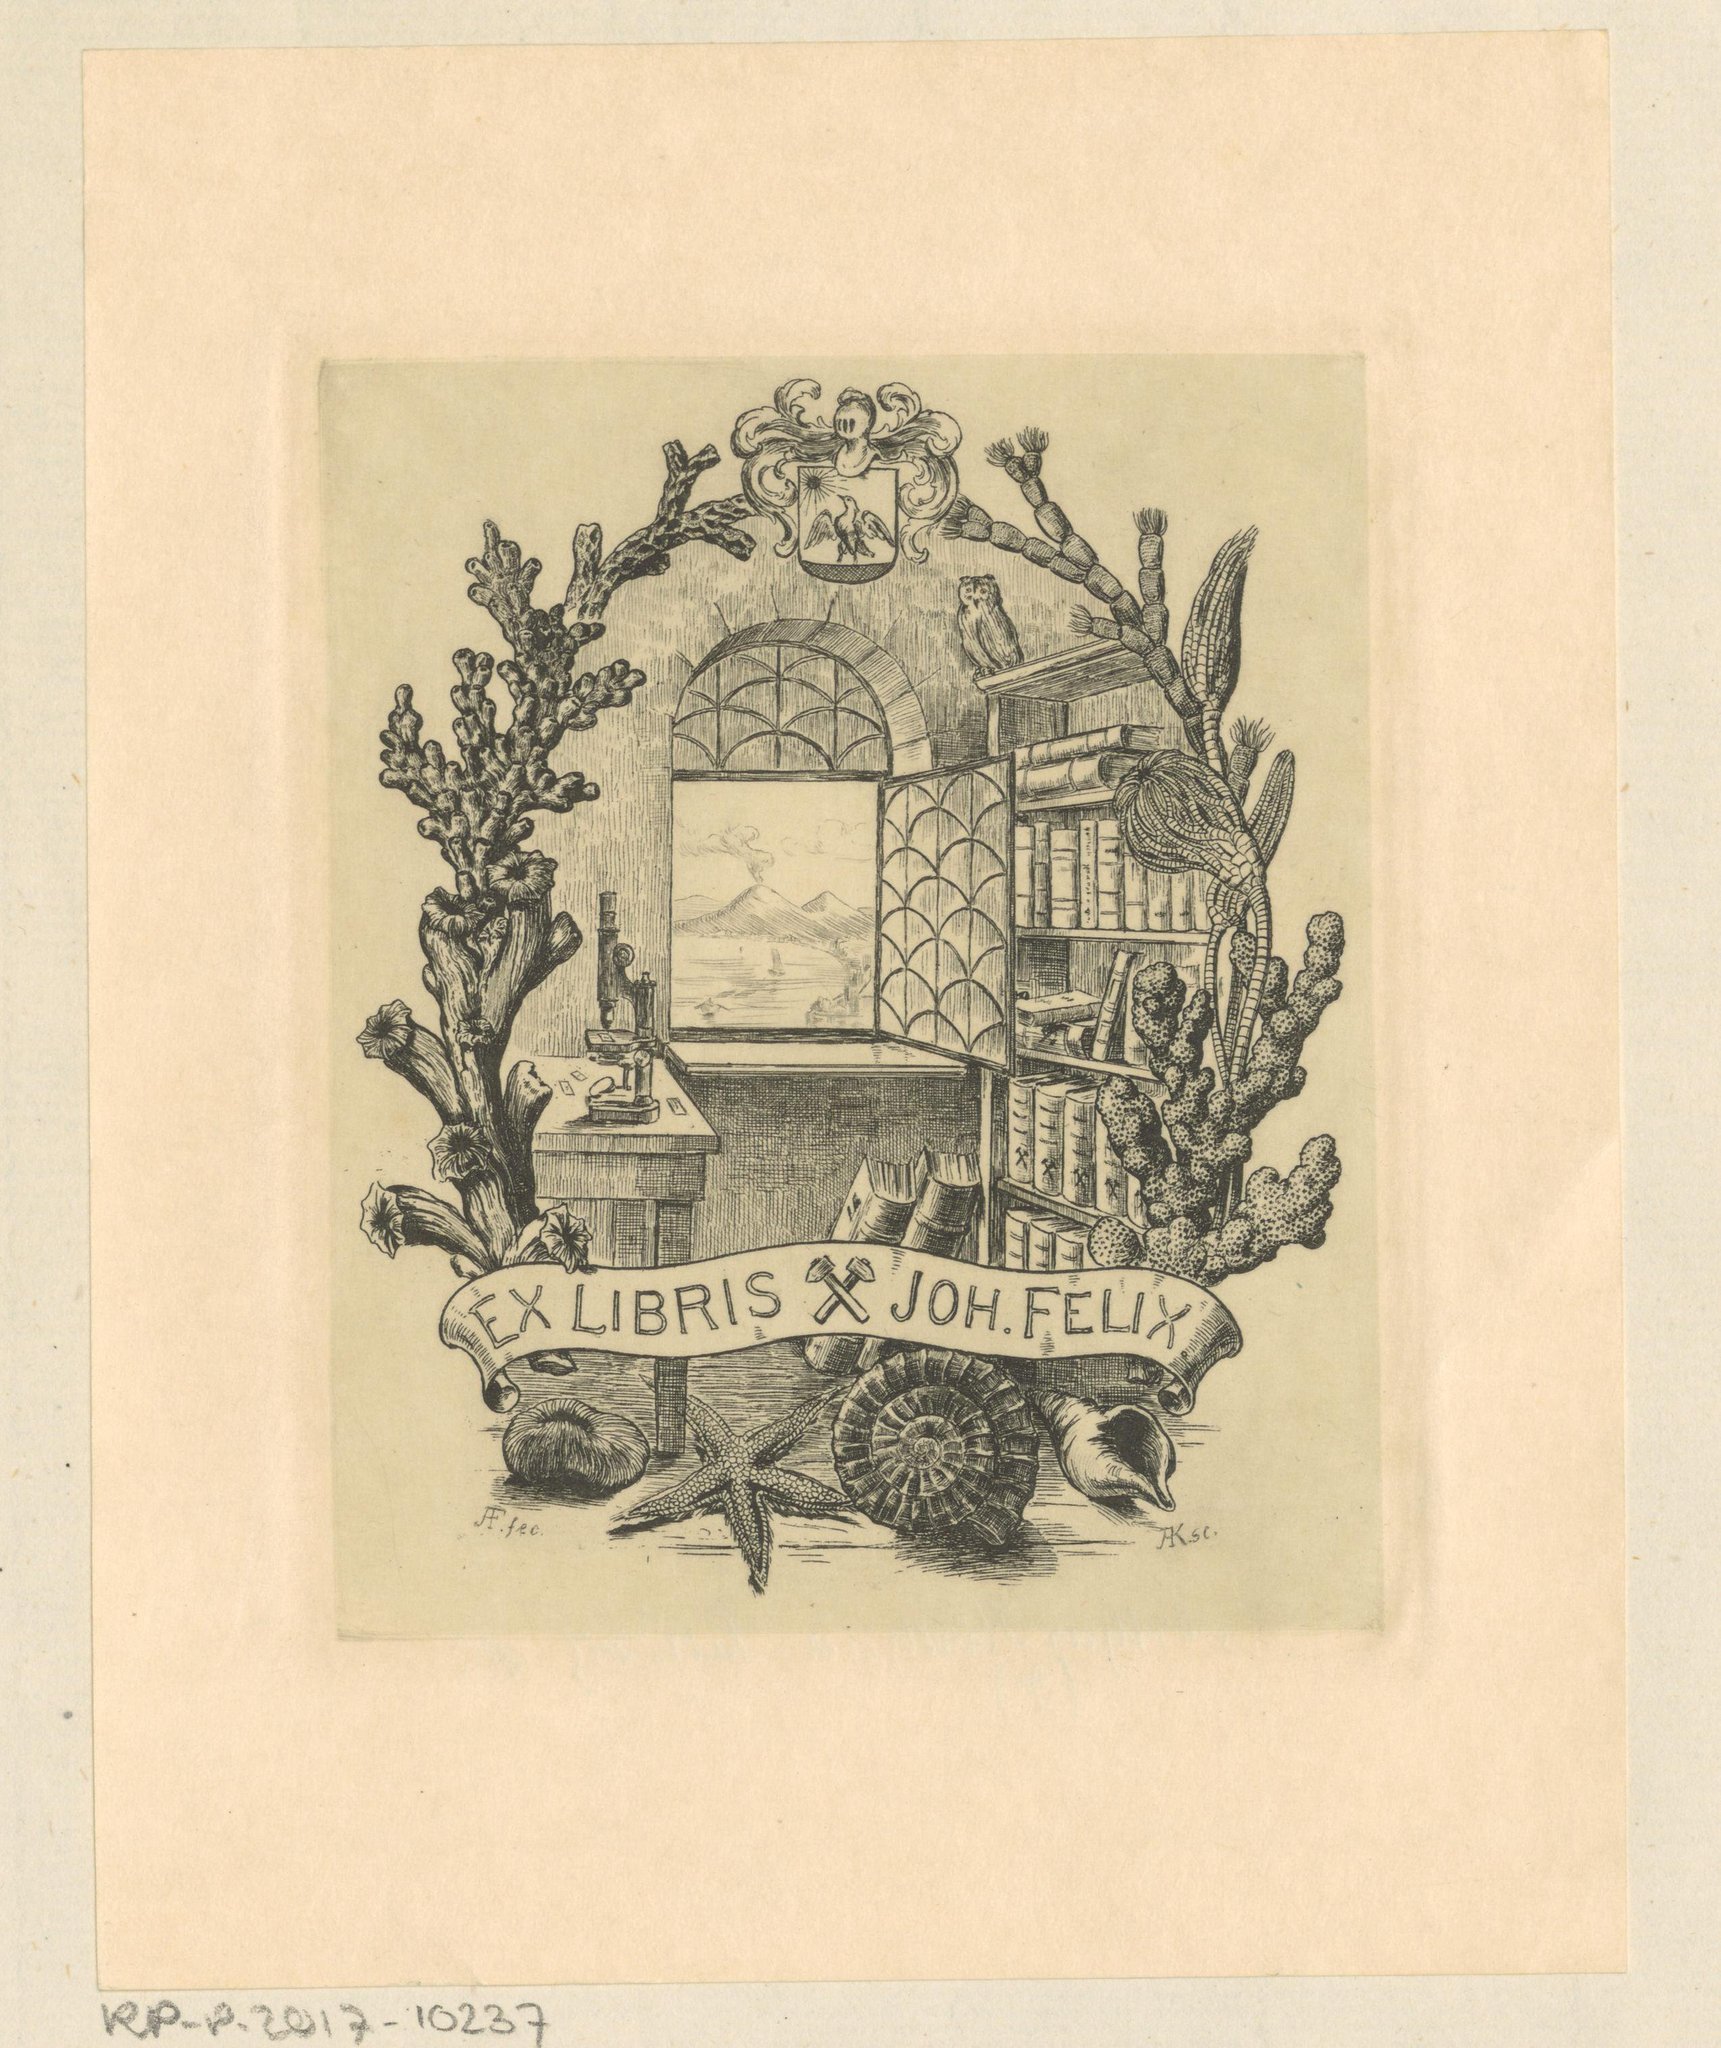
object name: bookplate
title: Ex libris van Joh. Felix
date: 1880-1949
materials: paper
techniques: etching, intaglio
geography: germany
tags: coelenterata: coral, study; 'studiolo'; library, armorial bearing, heraldry, microscope